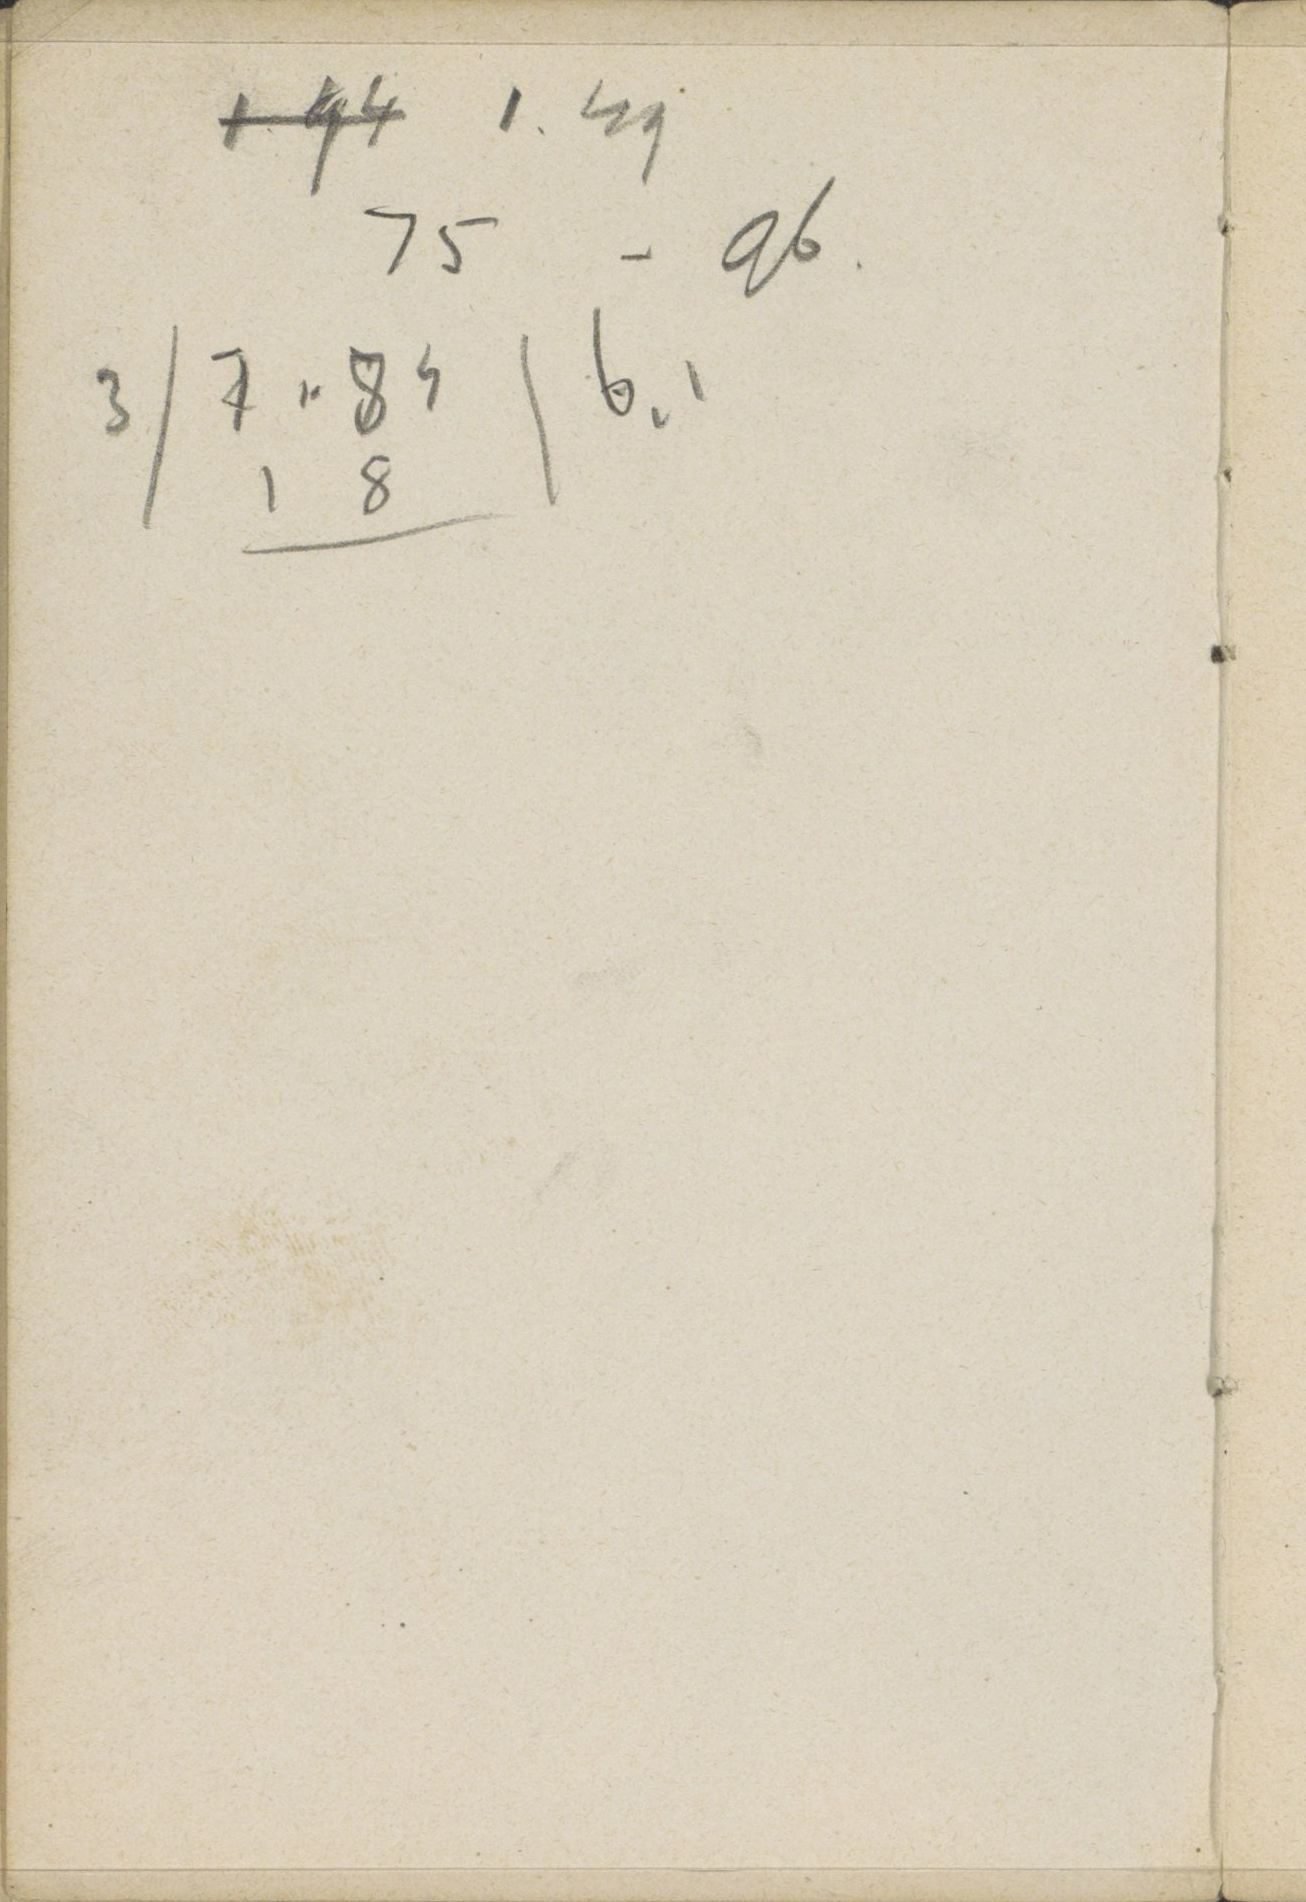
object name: sketchbook leaf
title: Annotaties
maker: george hendrik breitner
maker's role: draughtsman, painter, print maker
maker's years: 1857-1923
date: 1892-1923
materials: paper, pencil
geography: amsterdam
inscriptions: annotation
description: Aantekeningen. Pagina 74 uit een schetsboek met 45 bladen vervaardigd te Schwerin en Amsterdam.